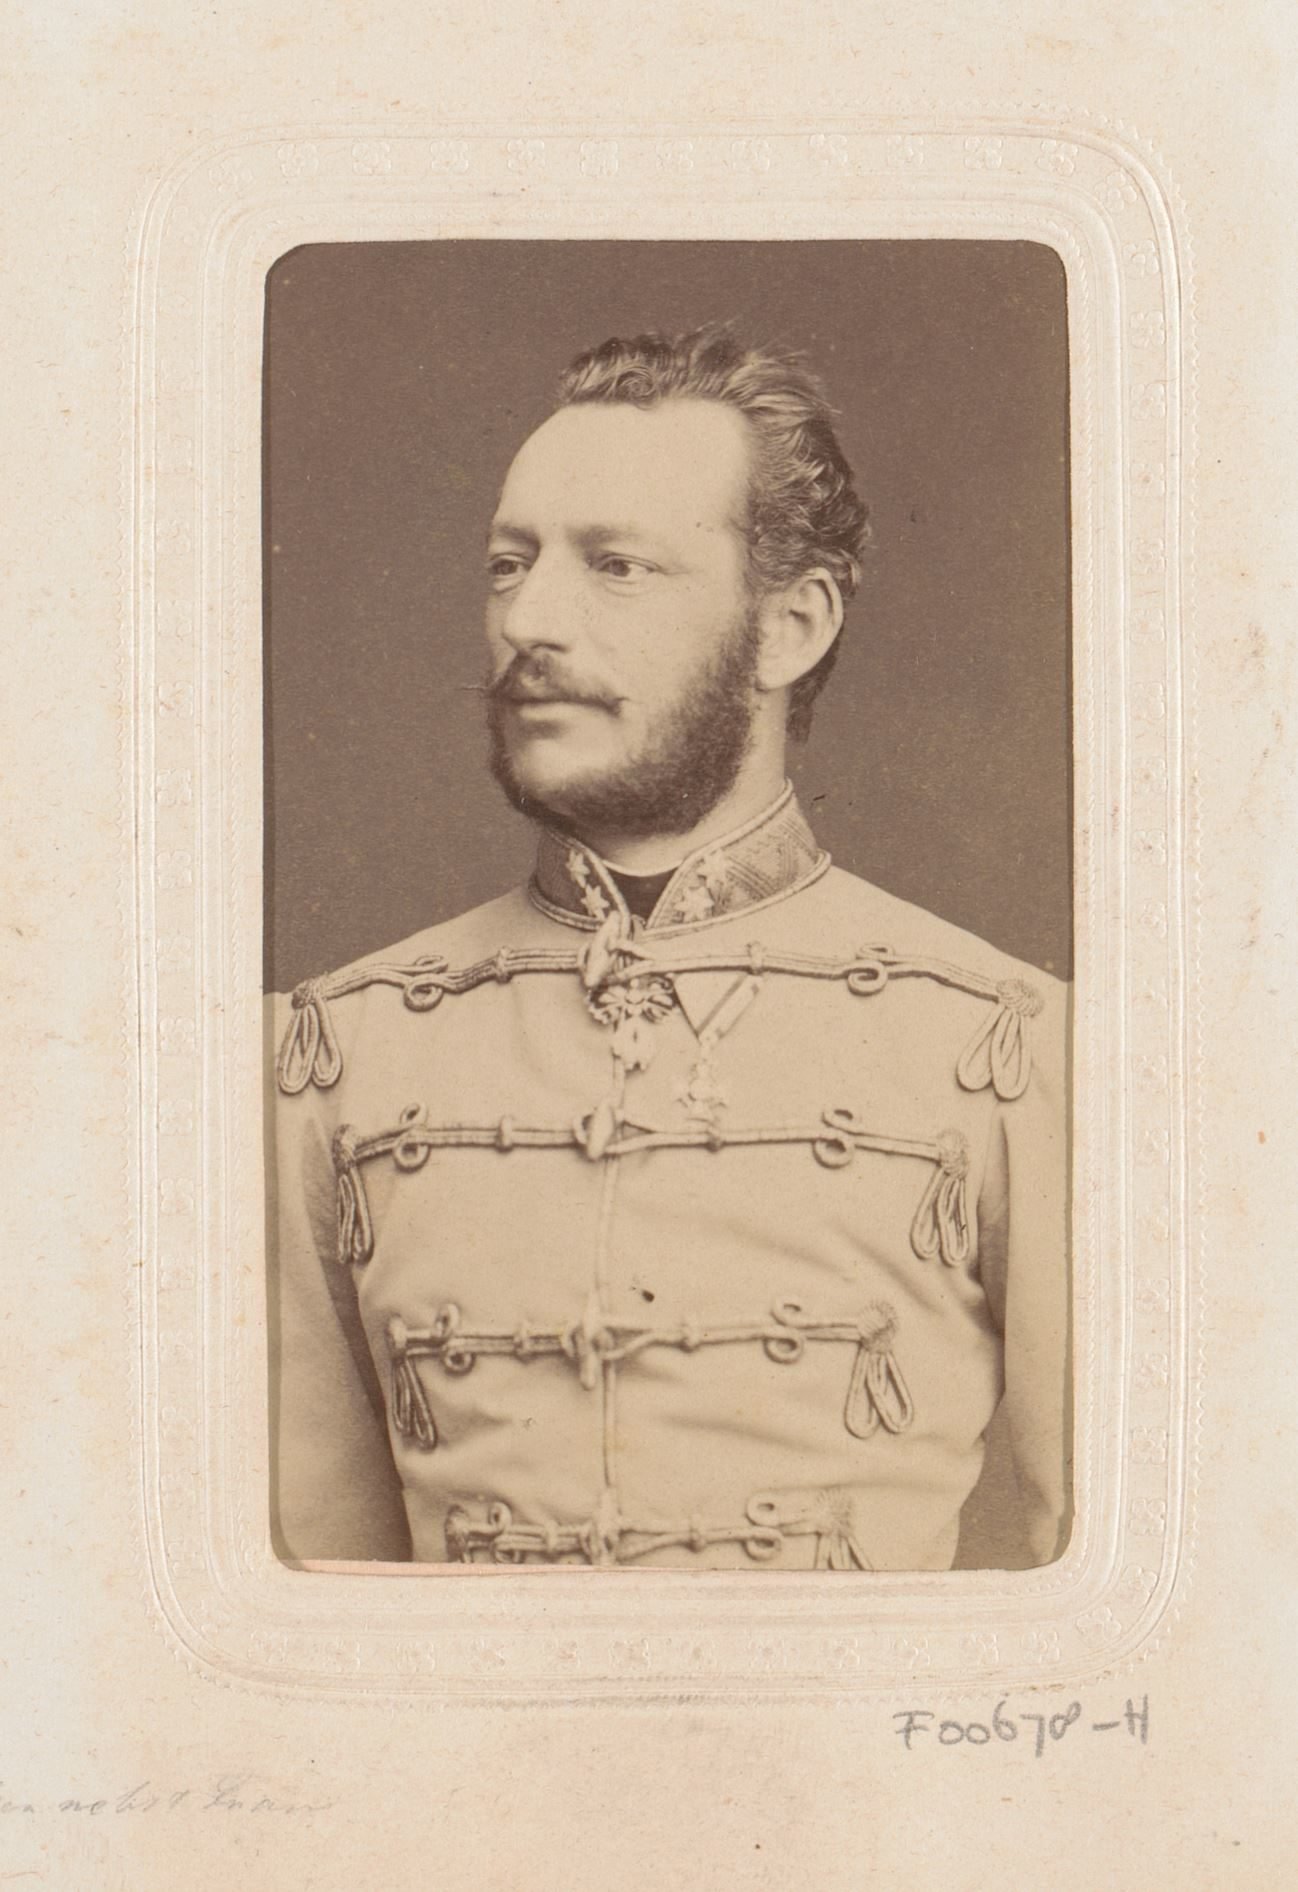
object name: photograph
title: Portret van een man in uniform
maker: ludwig angerer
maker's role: fotograaf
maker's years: 1827-1879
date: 1860-1880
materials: cardboard, photographic support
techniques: albumen print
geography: vienna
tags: historical persons, (military) uniforms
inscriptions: inscription: ‘L. Angerer/ k.k. Hof-Photograph in Wien/ Stadt, Johannesgasse (...)’